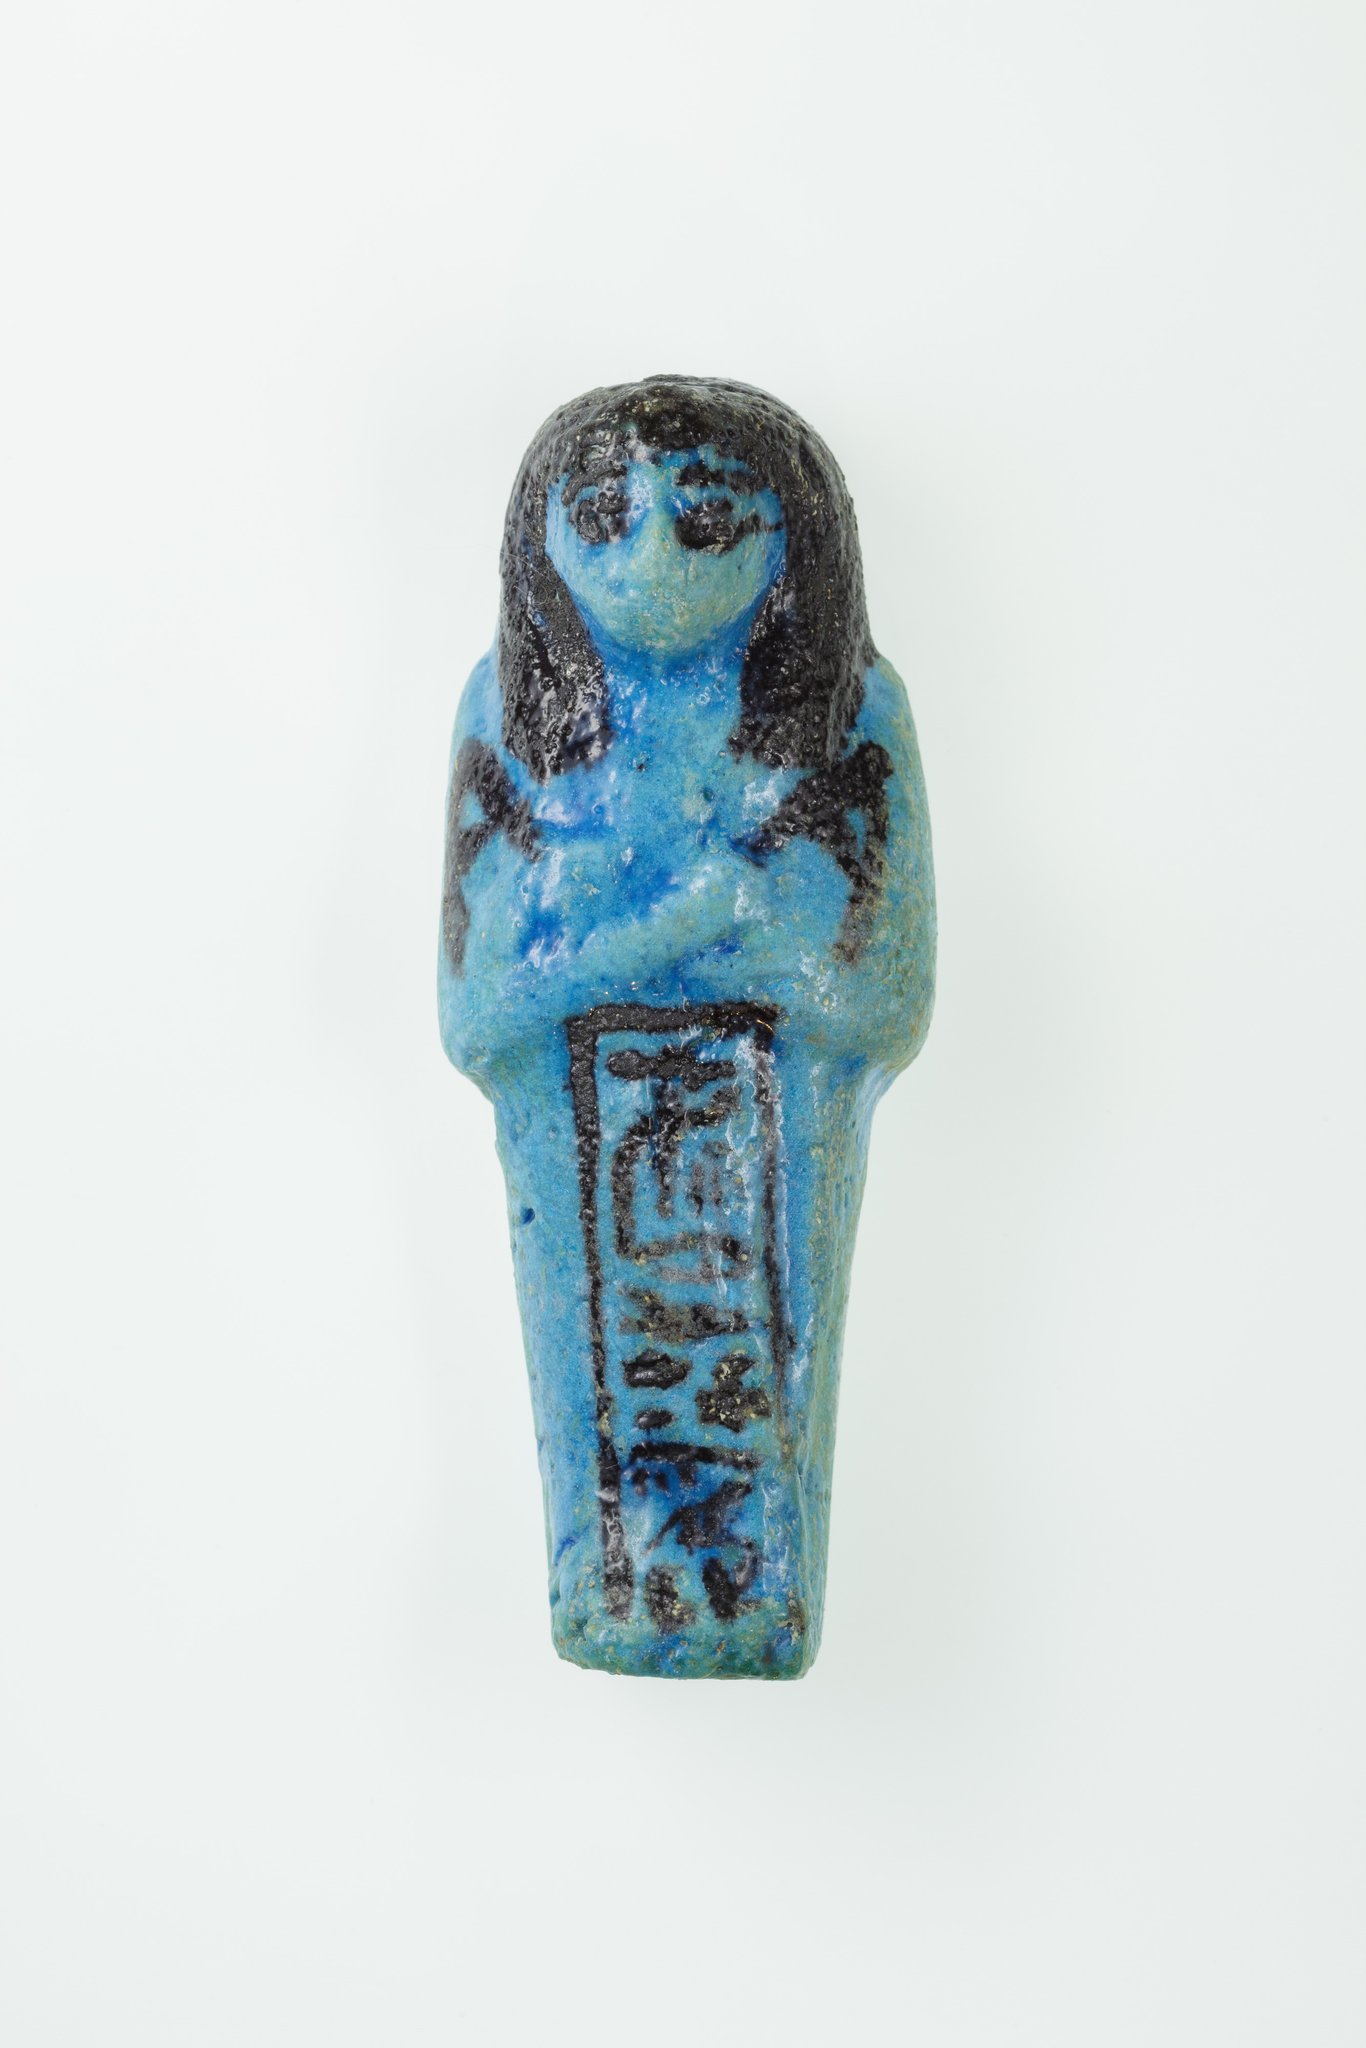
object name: shabti, worker, nauny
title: Worker Shabti of Nauny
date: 1050 BCE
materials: faience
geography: egypt